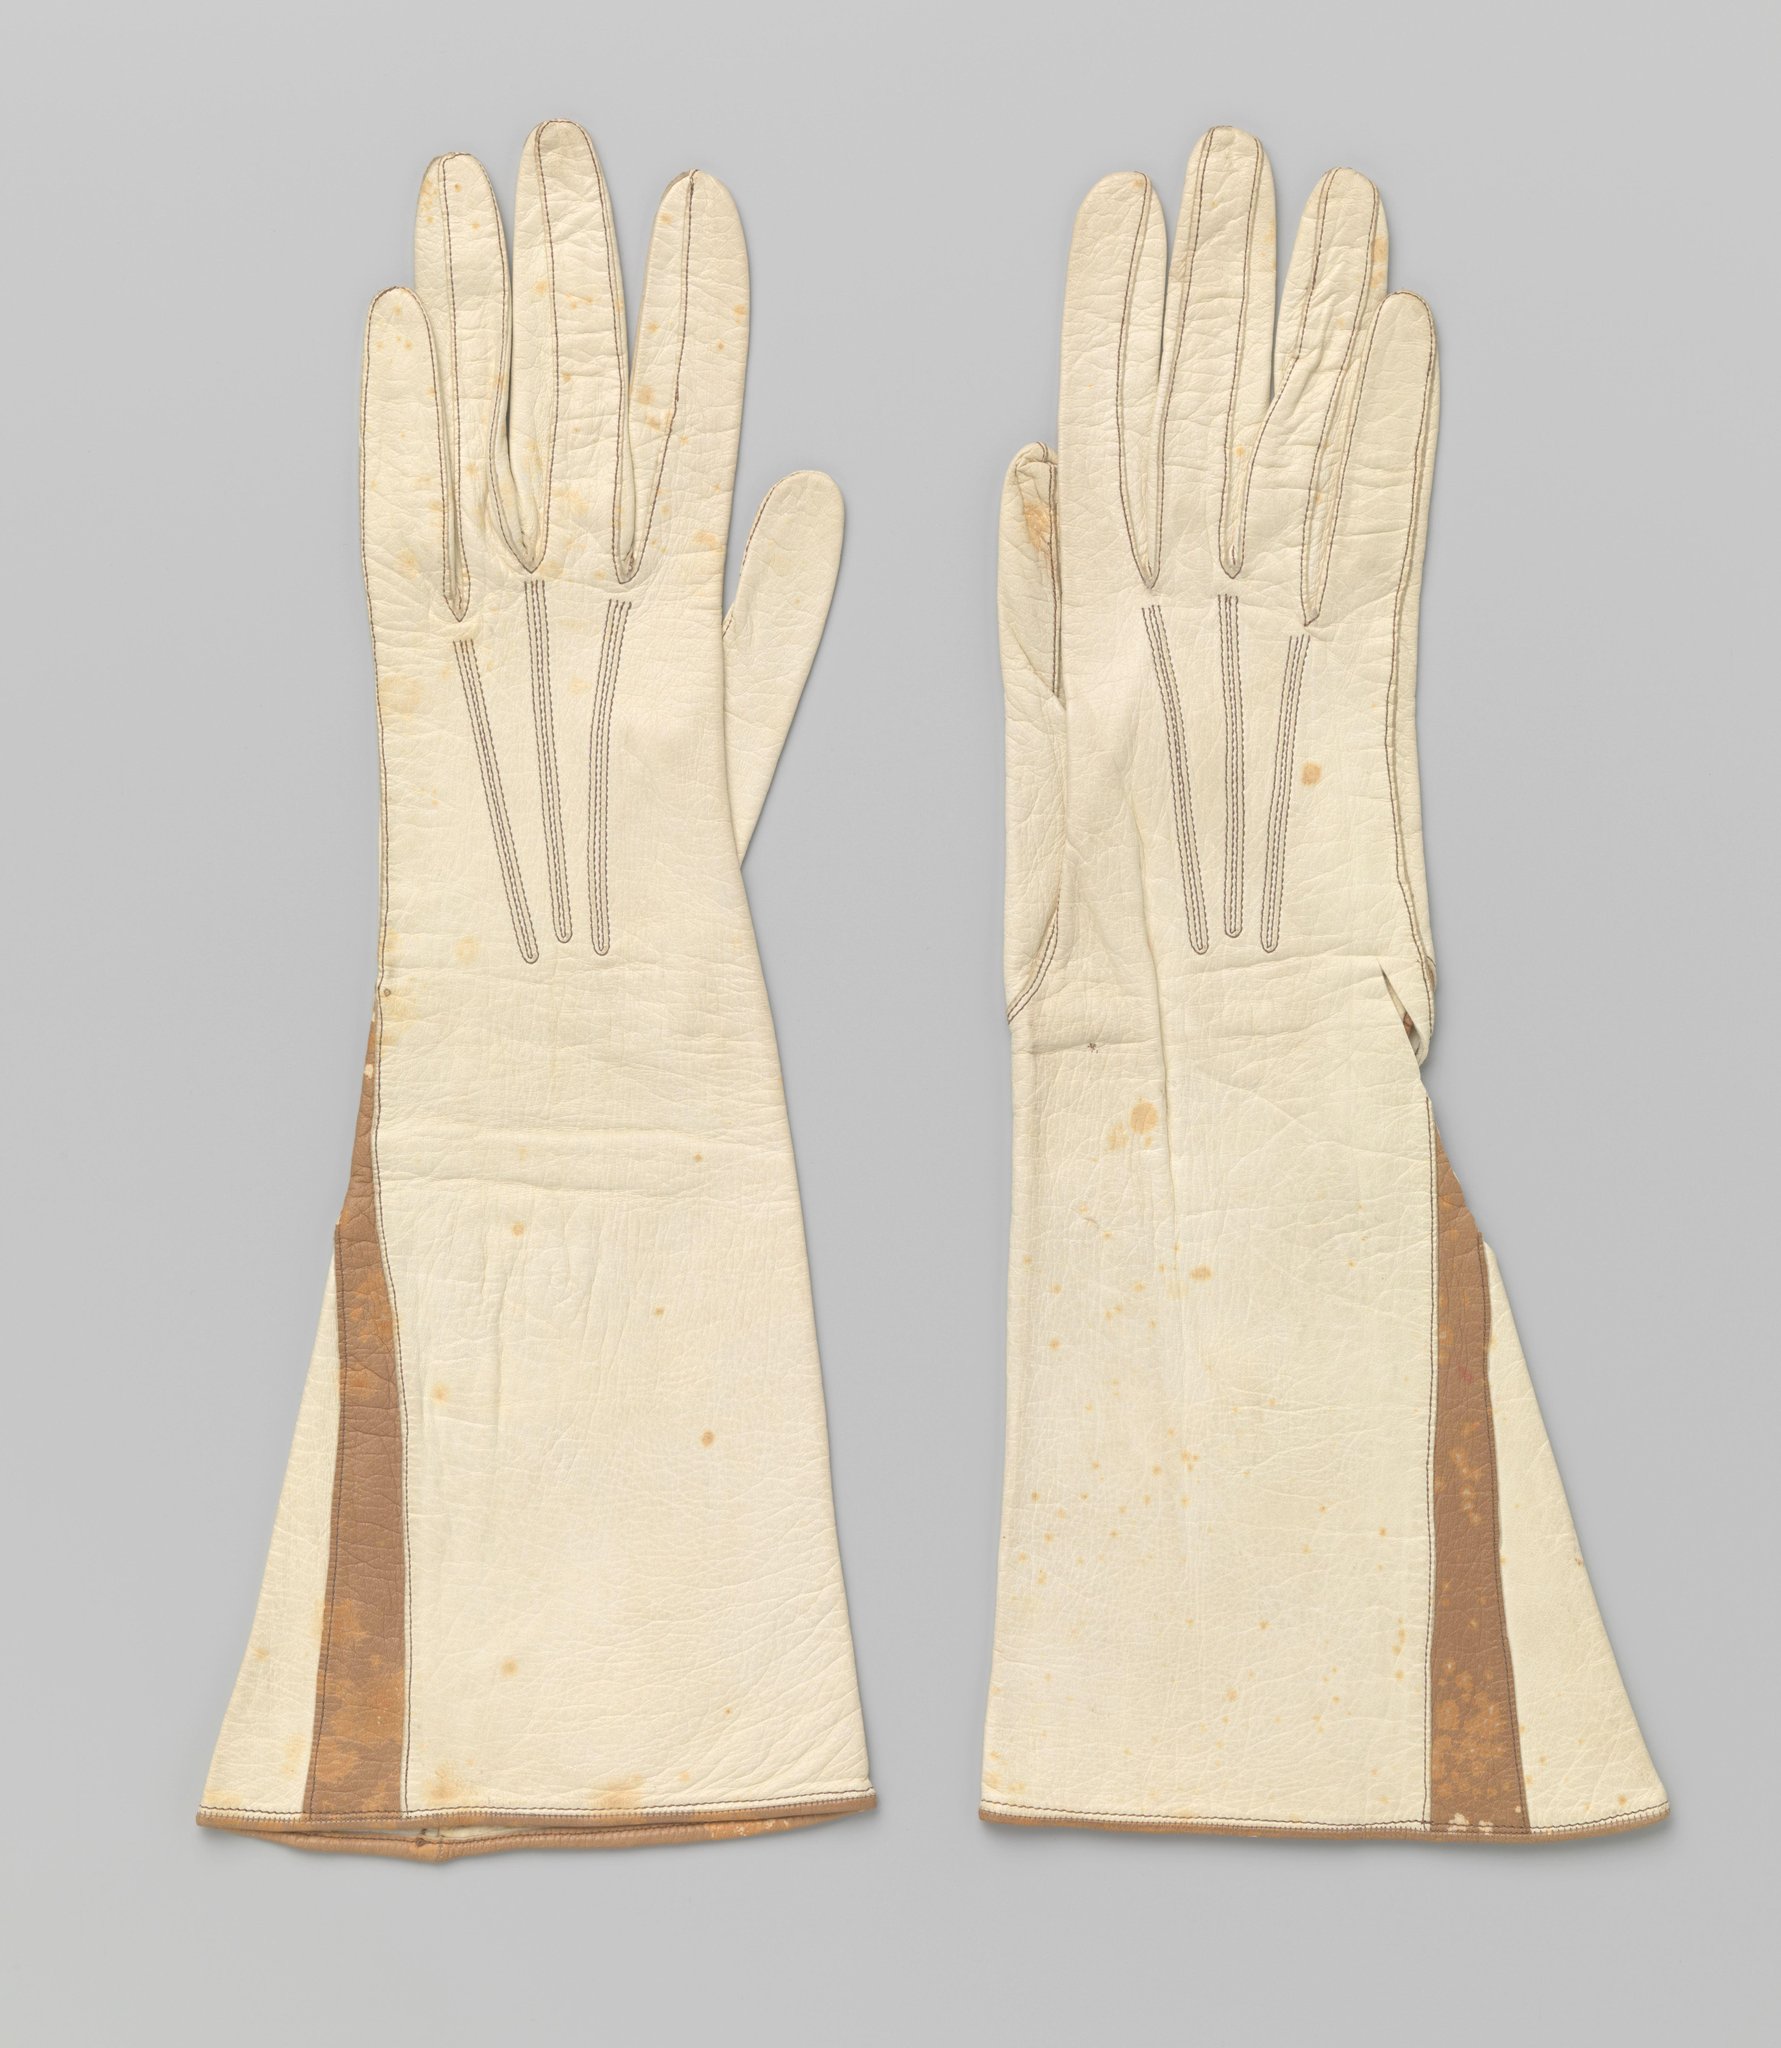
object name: clothing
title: Pair of two-tone gloves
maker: Anonymous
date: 1900-1915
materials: leather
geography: netherlands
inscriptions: stamp: ‘tekst; afbeelding’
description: Linkerhandschoen van beige wasleer. Afgezet met sierrand van bruin wasleer. Op de rug drie lijnen. Gestikt met bruine draad.